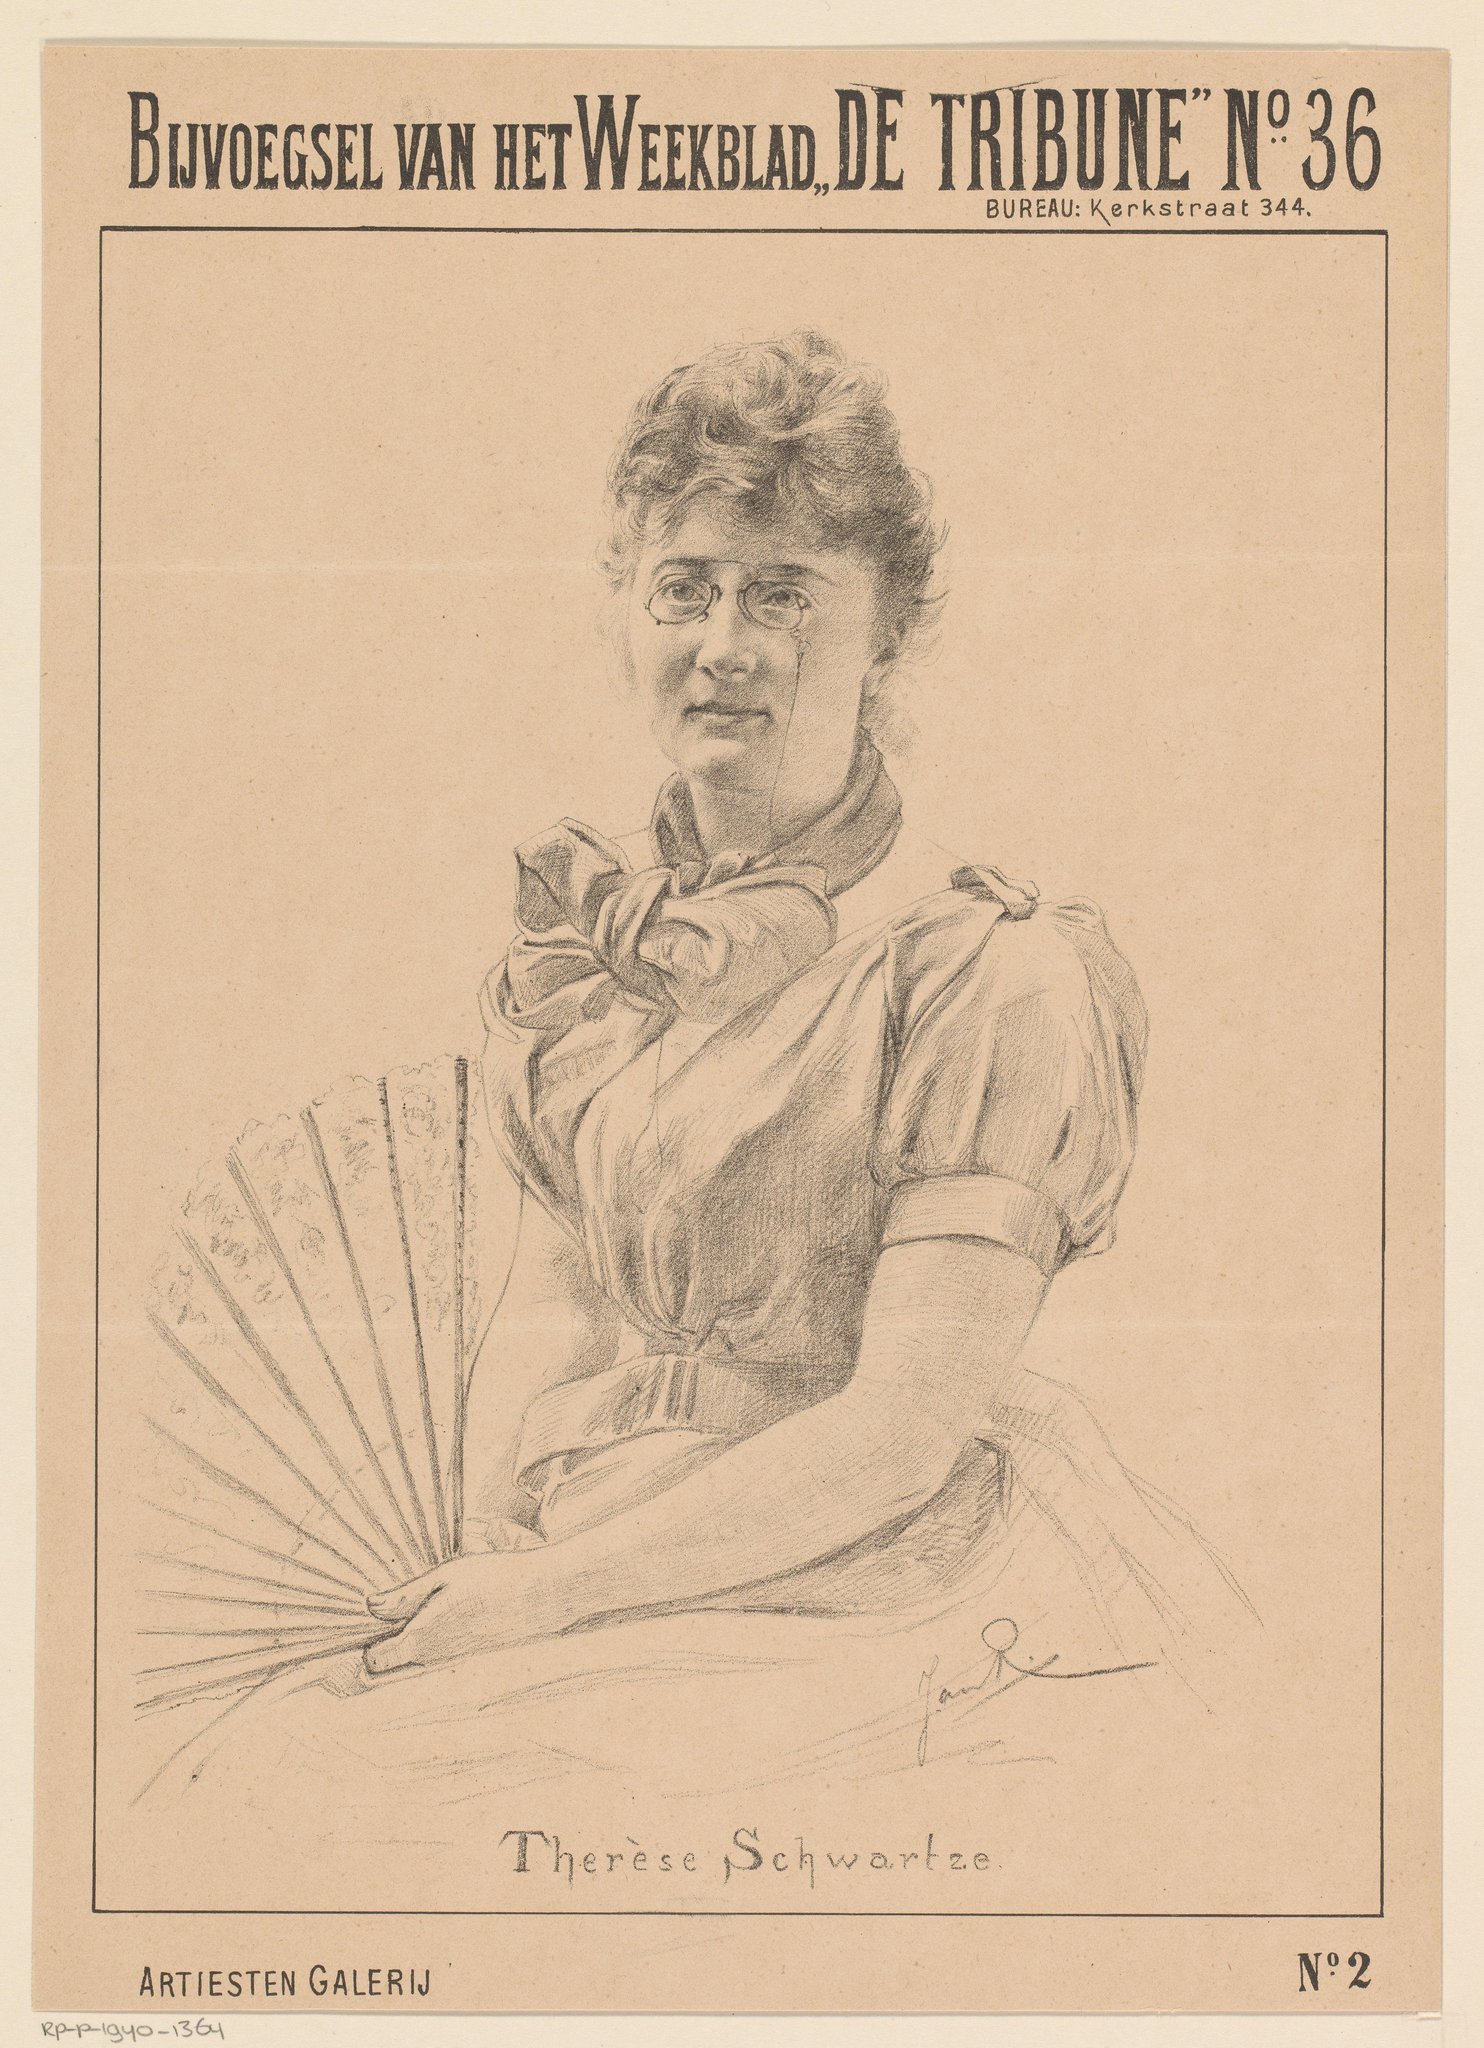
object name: print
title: Portret van Thérèse Schwartze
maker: jan rinke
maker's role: painter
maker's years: 1863-1922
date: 1909-1922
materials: paper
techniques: lithograph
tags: amsterdam, painter, draughtsman, thérèse schwartze, historical persons, portrait, self-portrait of artist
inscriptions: collector's mark: Lugt 2228, collector's mark: Lugt 2760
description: Prent gebruikt in een editie van De Tribune [1909-1937].